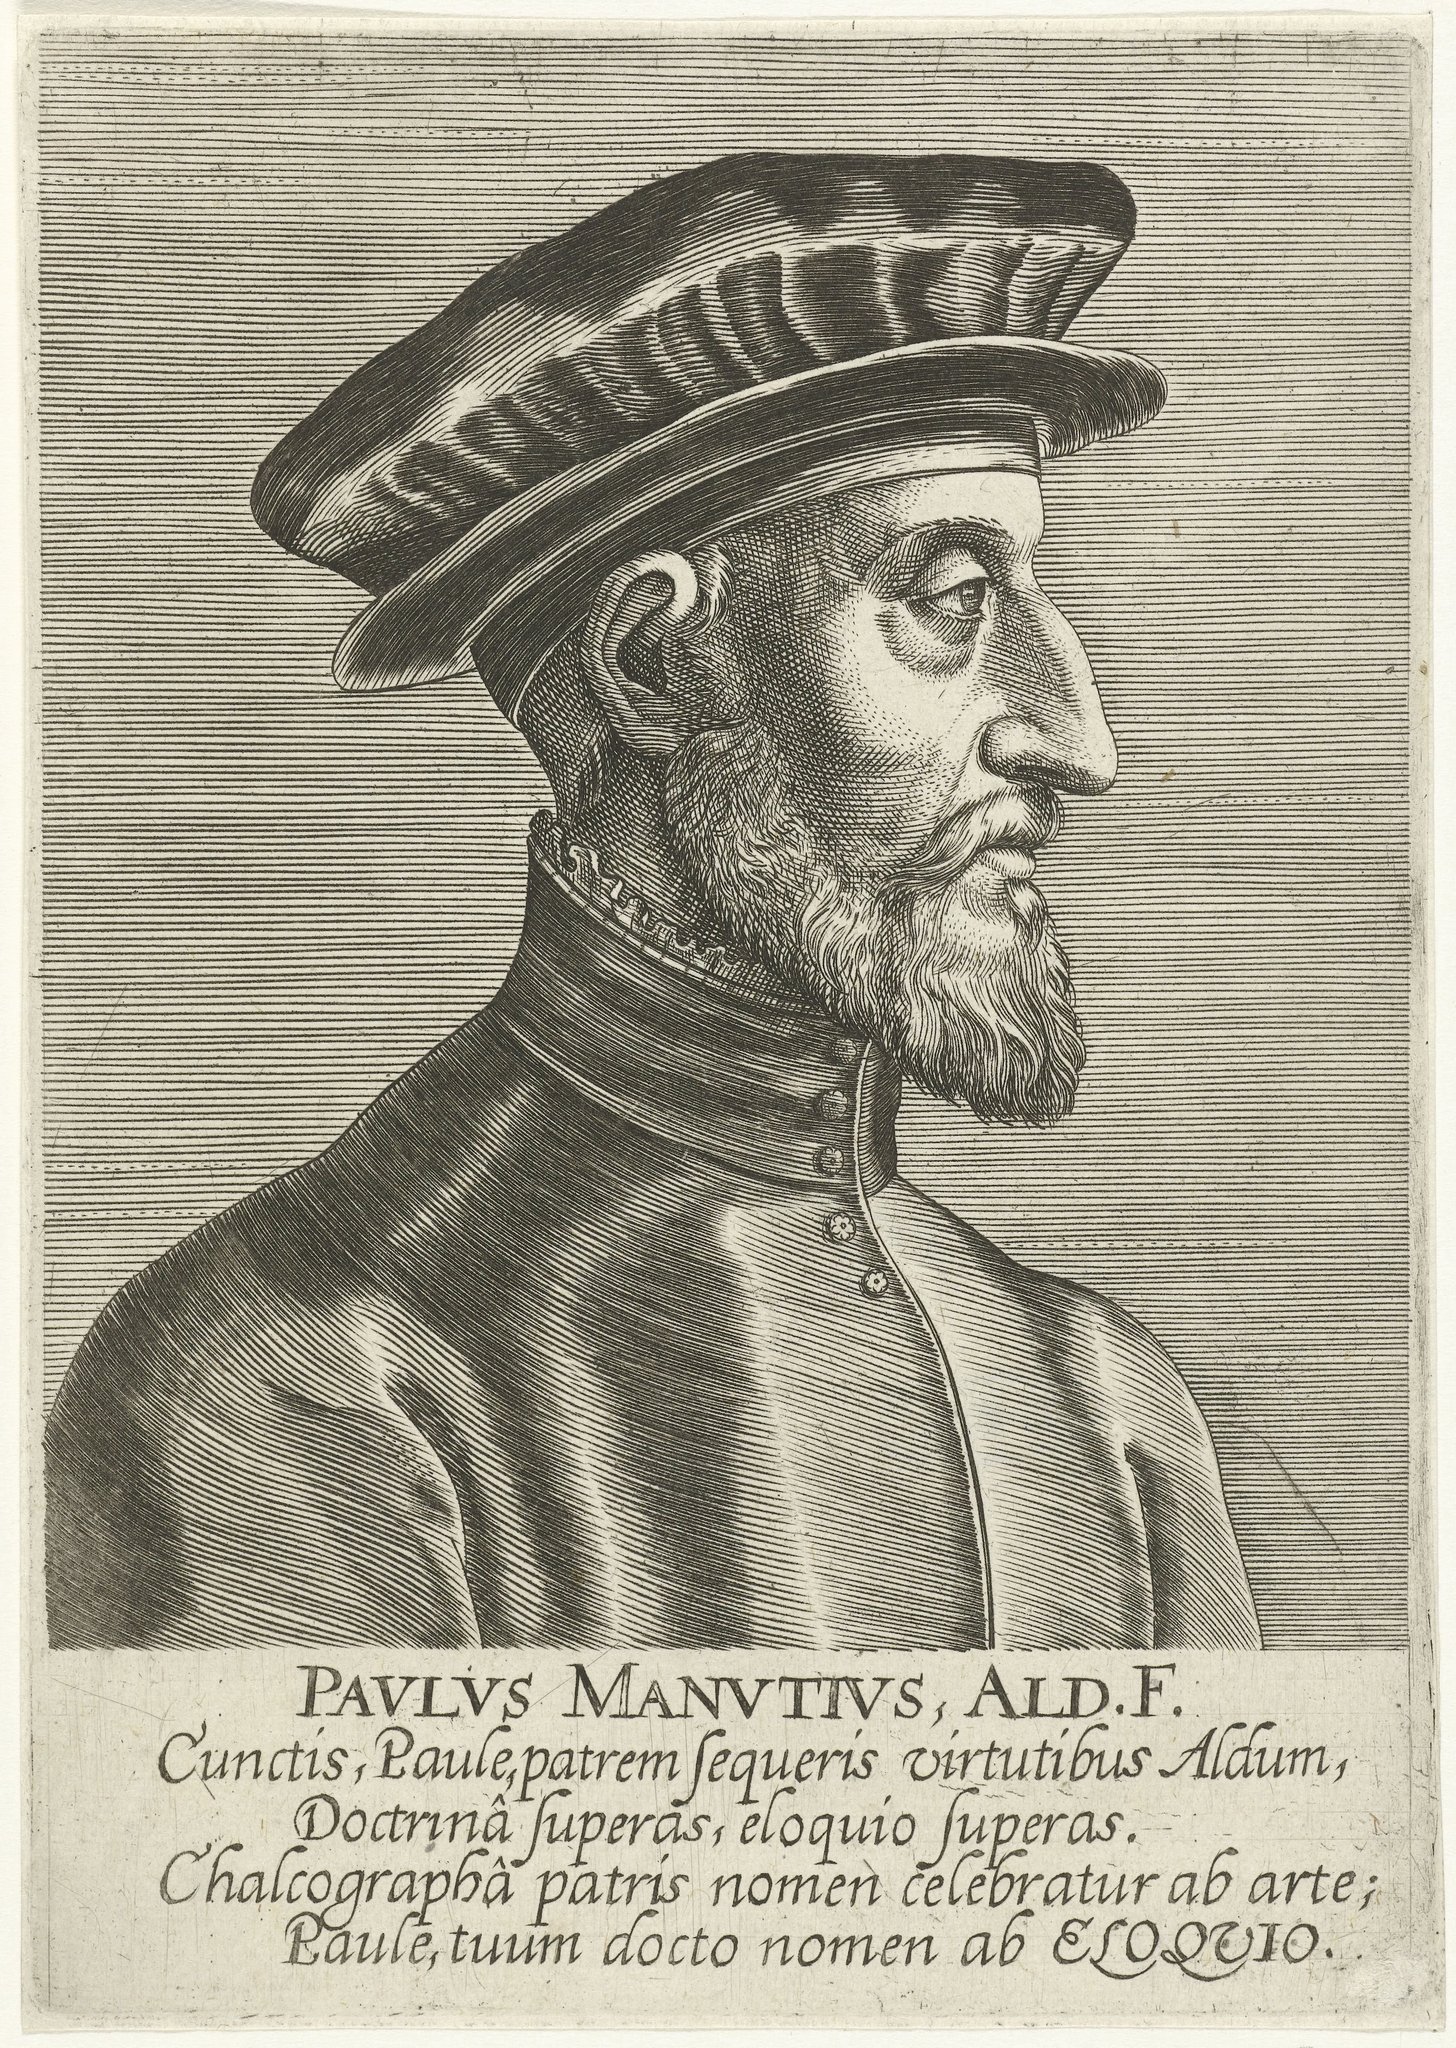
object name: print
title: Pavlvs Manvtivs, Ald. F.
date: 1587-1606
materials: paper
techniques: engraving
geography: antwerp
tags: venice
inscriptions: collector's mark: Lugt 2228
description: Portret van Paolo Manuzio, Italiaanse humanist en uitgever. In profiel naar links. De prent heeft een Latijns onderschrift en maakt deel uit van een serie van beroemde geleerden